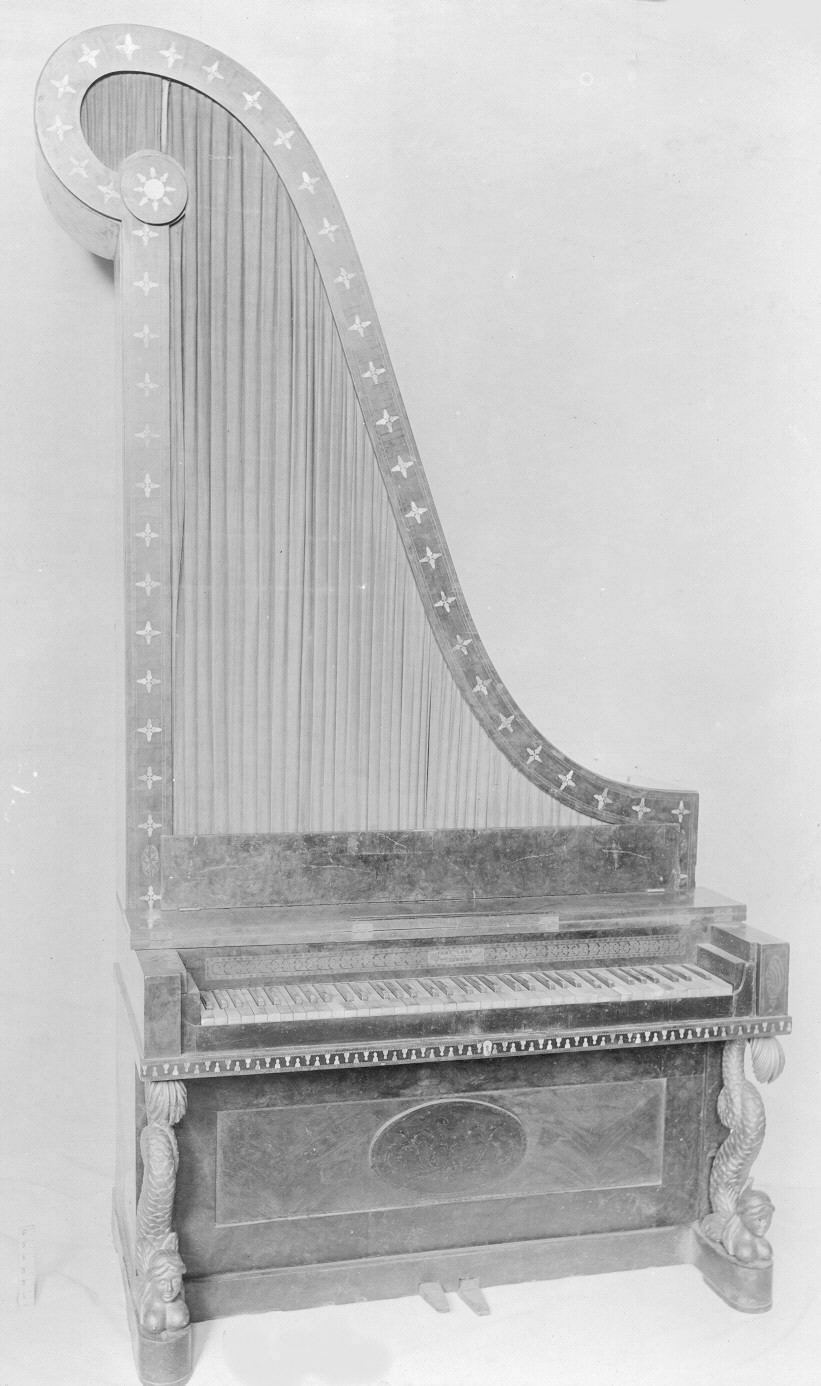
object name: upright giraffe piano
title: Upright (Giraffe) Piano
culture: german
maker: carl lang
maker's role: maker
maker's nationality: german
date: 1830-1840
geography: germany